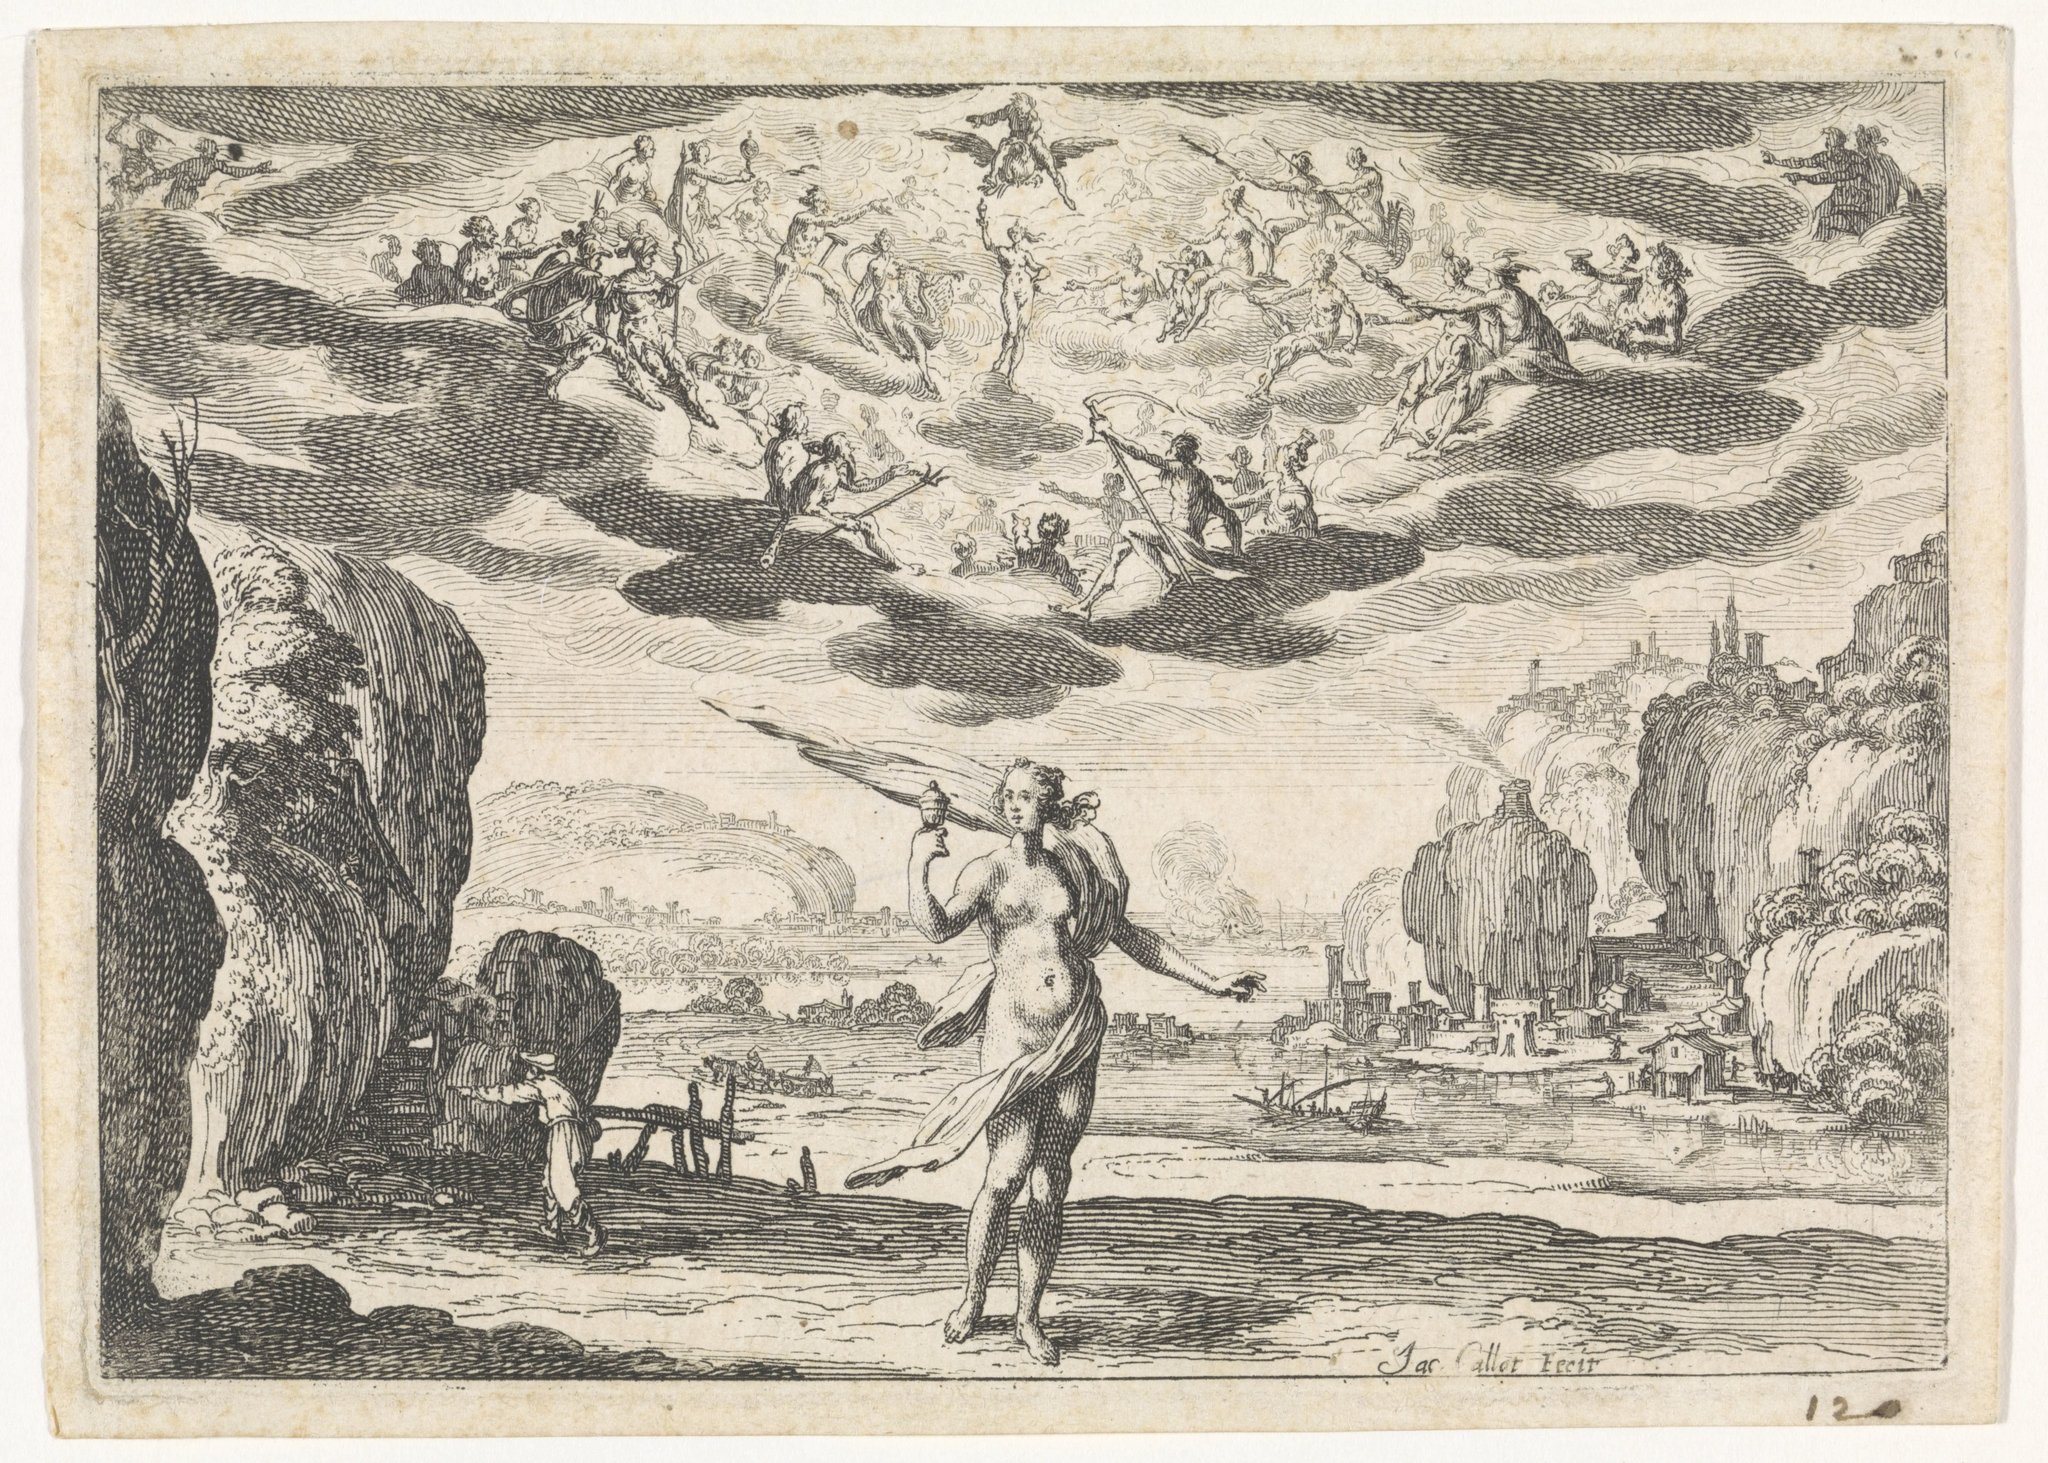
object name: print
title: Pandora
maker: jacques callot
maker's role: draughtsman, print maker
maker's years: 1592-1635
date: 1625-1626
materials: paper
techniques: etching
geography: nancy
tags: the gods adorning pandora, (story of) pandora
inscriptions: number: ‘12’, collector's mark: Lugt 2228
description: In een berglandschap staat een vrijwel naakte vrouw met een gesloten beker in de rechterhand. Aan de hemel op een wolkenpartij is zij nogmaals zichtbaar, omringd door de Olympische goden met Jupiter in het midden.